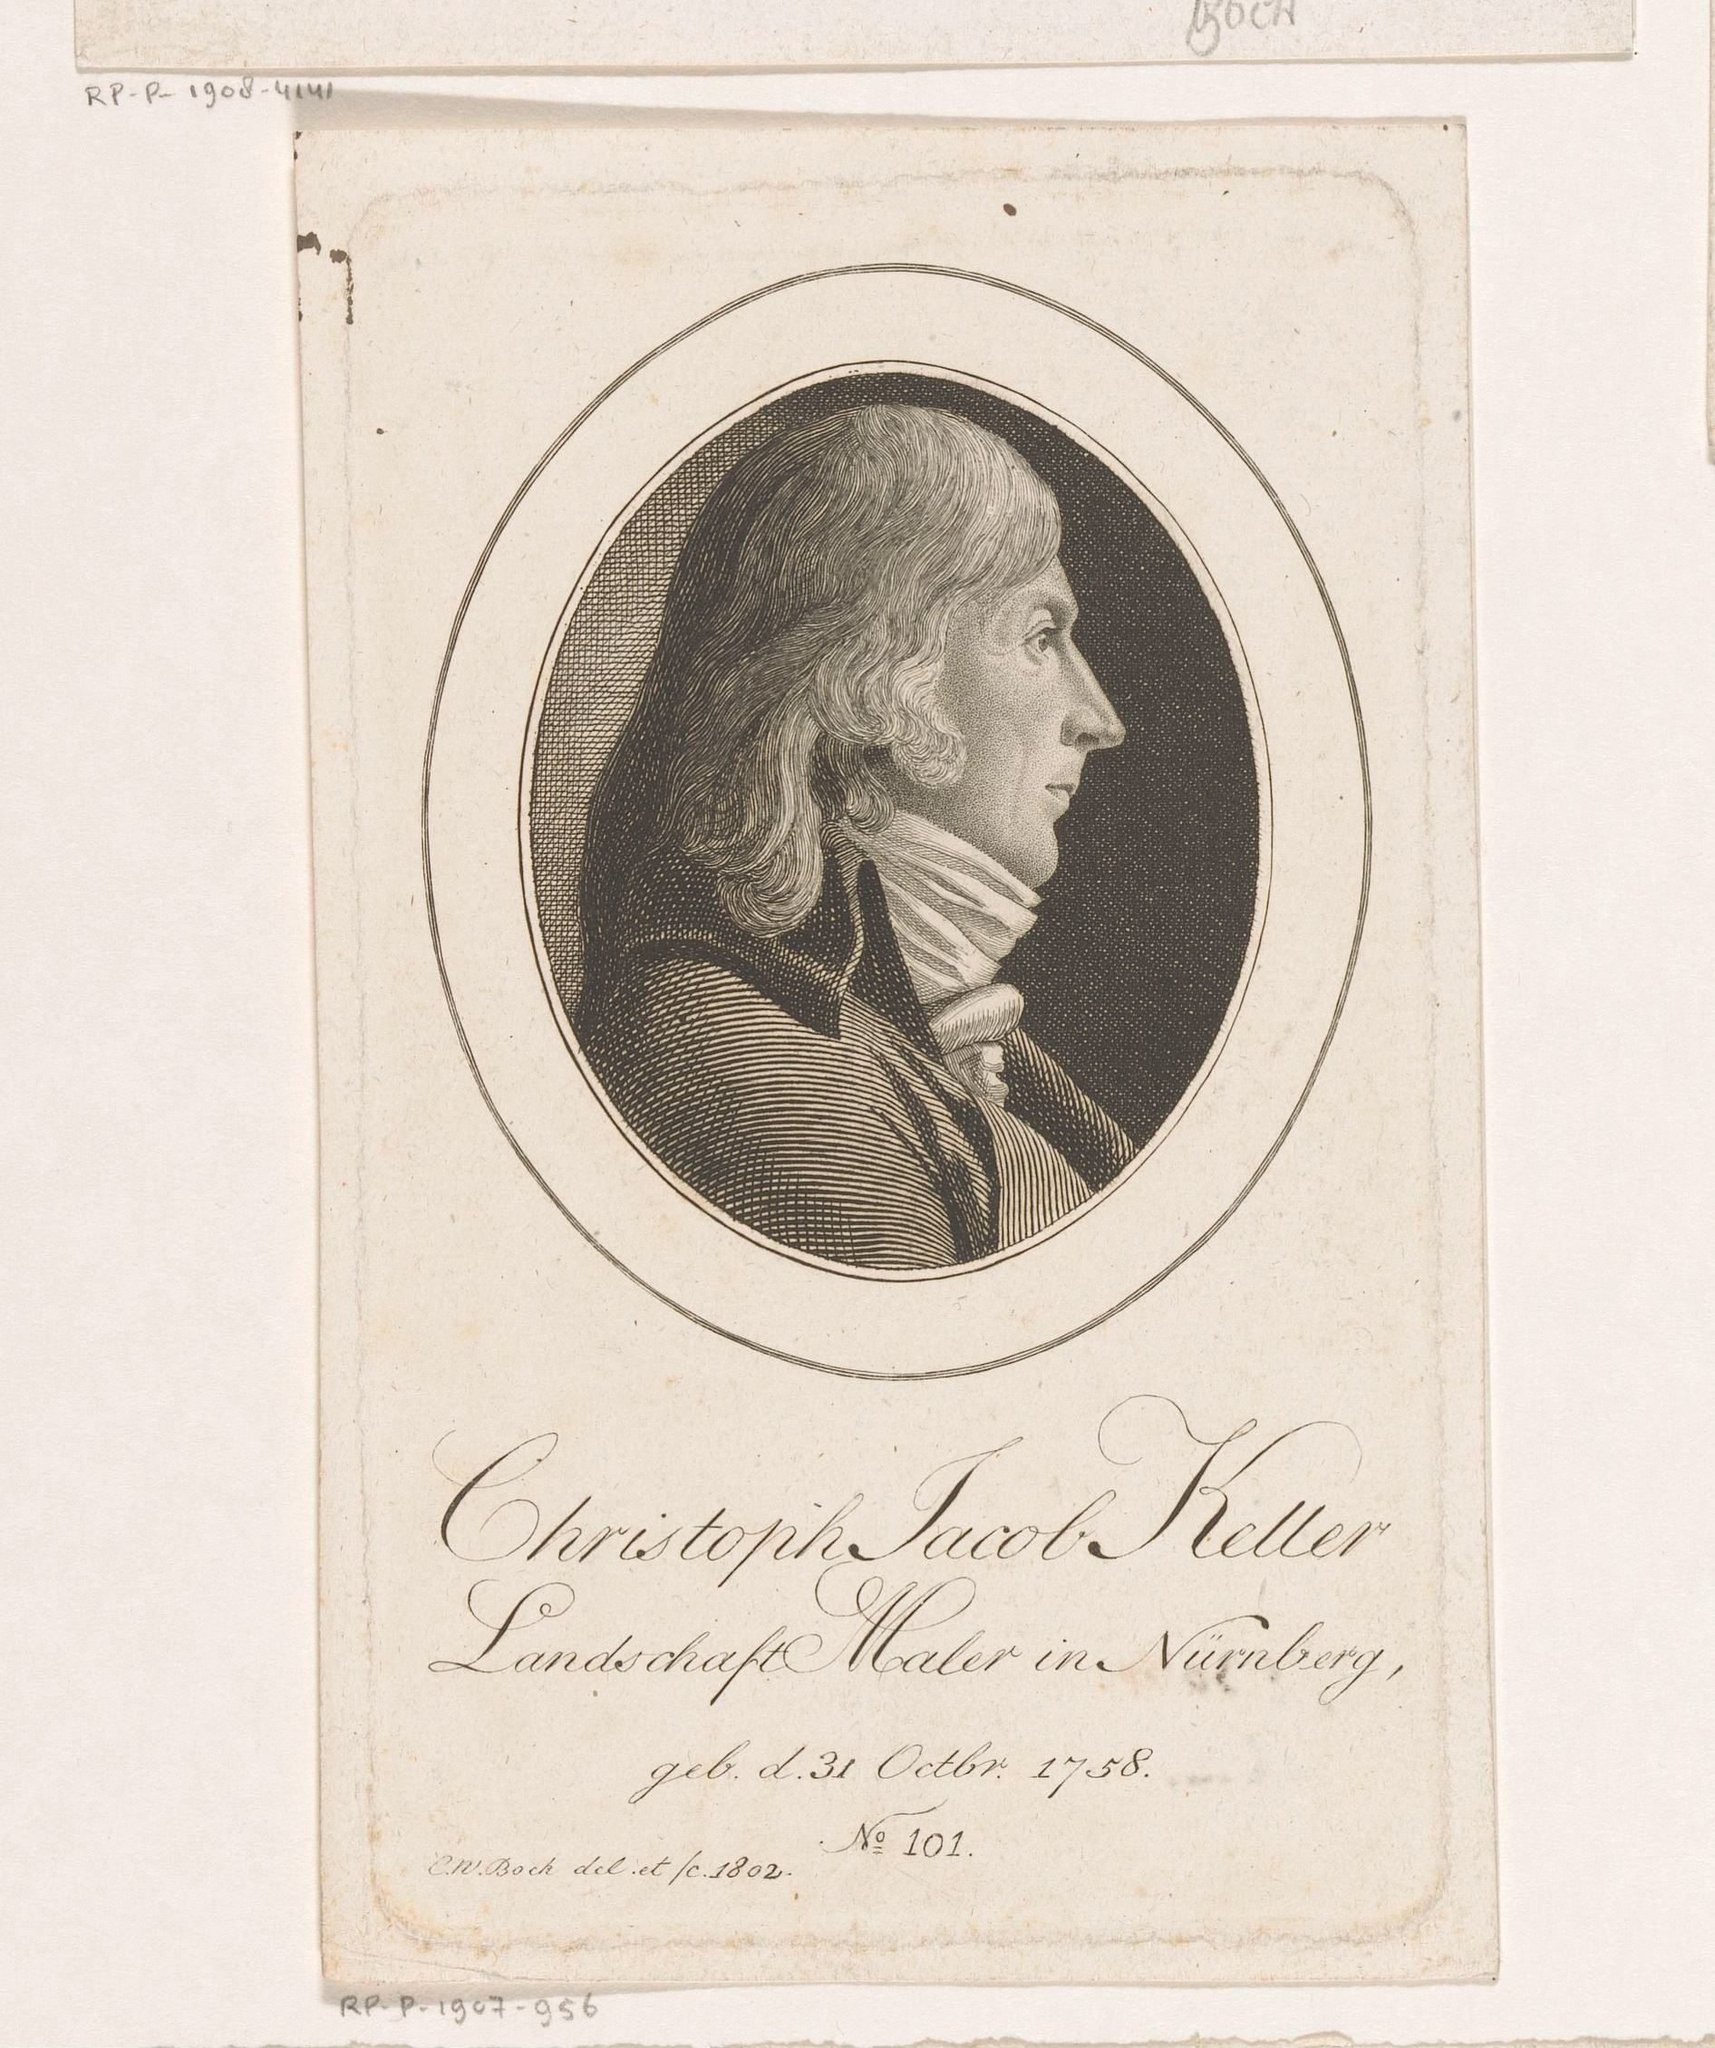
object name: print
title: Portret van Christoph Jacob Keller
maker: christoph wilhelm bock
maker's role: print maker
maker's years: 1755-1836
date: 1802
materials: paper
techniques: engraving, etching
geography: nuremberg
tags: painter, portrait, self-portrait of painter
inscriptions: collector's mark: Lugt 2228